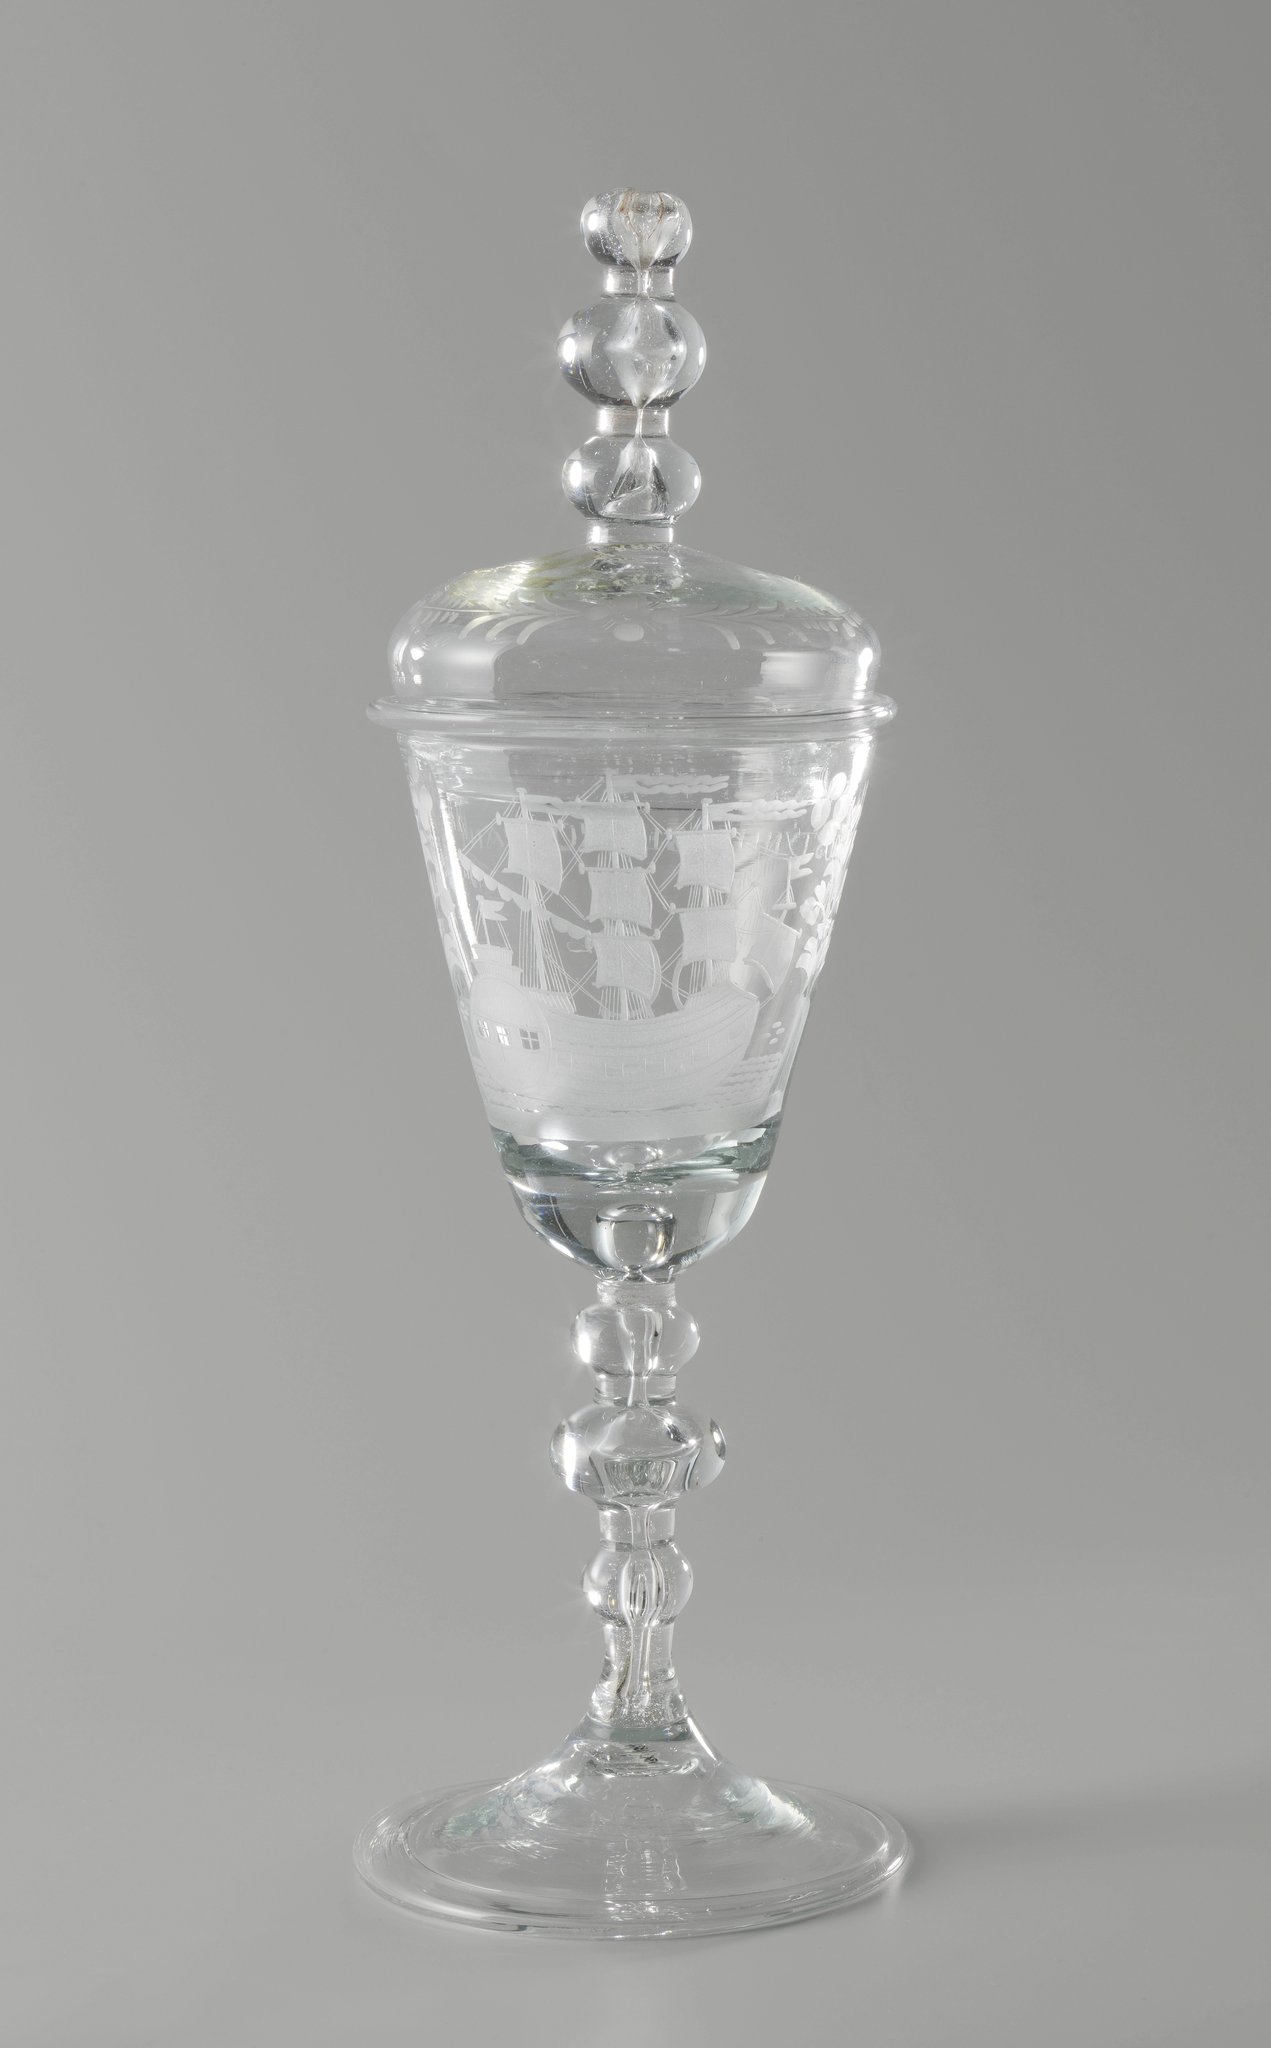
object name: goblet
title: Bokaal met deksel, met een driemaster en het opschrift: HET WEL VAREN VAN DE OOSTYNDYESE KOMPANIE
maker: Anonymous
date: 1725-1750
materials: glass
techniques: glassblowing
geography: germany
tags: verenigde oostindische compagnie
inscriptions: inscription: ‘VOC’, inscription: ‘HET WEL VAREN VAN DE OOSTYNDYESE KOMPANIE’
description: Conische voet met omgeslagen rand. Balustervormige stam met drie knopen en luchtbellen. Trechtervormige kelk met afgeronde onderzijde. Op de kelk een driemaster op een gematteerde grond, geflankeerd door bladertakken. Op de keerzijde het monogram van de Verenigde Oostindische Compagnie, VOC, onder de inscriptie: HET WEL VAREN VAN DE OOSTYNDYESE KOMPANIE. Het glas in gelegateerd met deksel. Het deksel is echter niet oorspronkelijk.